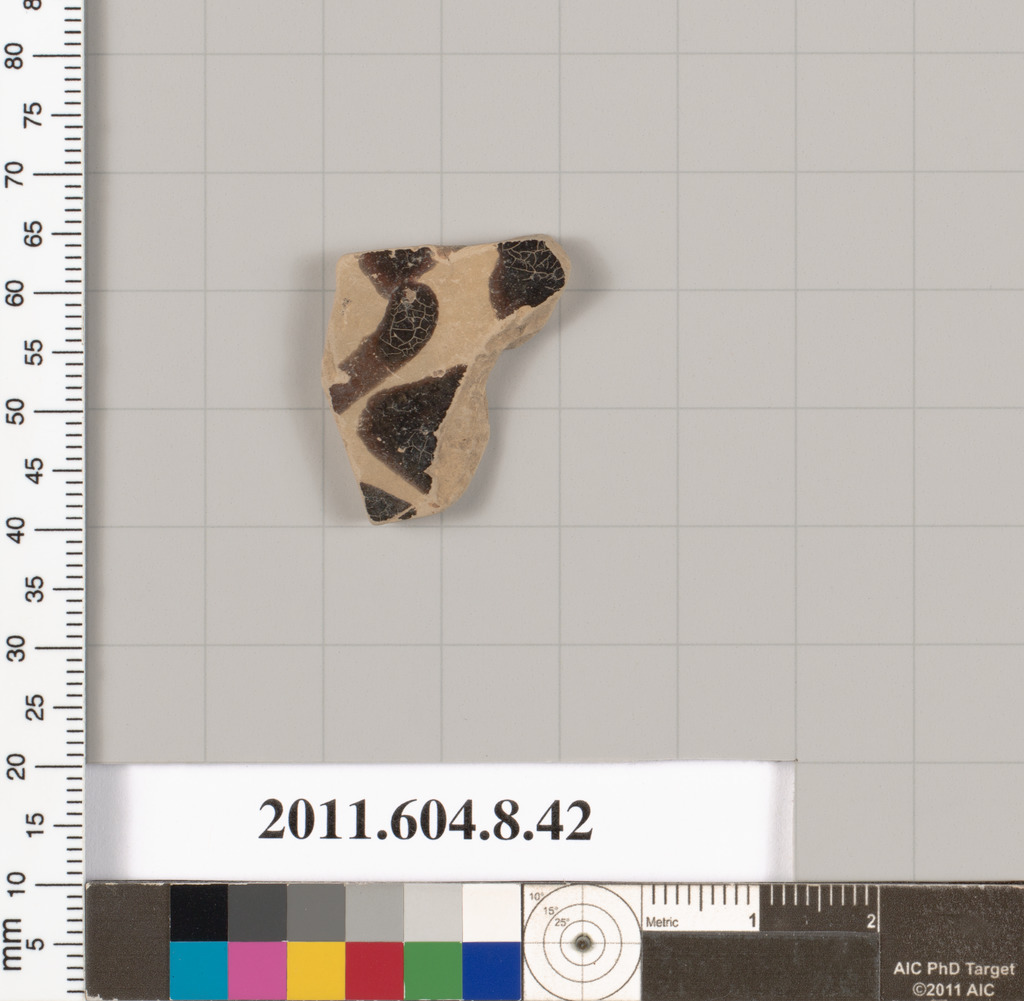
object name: undetermined closed shape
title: Terracotta fragment of a closed shape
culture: greek, corinthian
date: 600-501 BCE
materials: terracotta